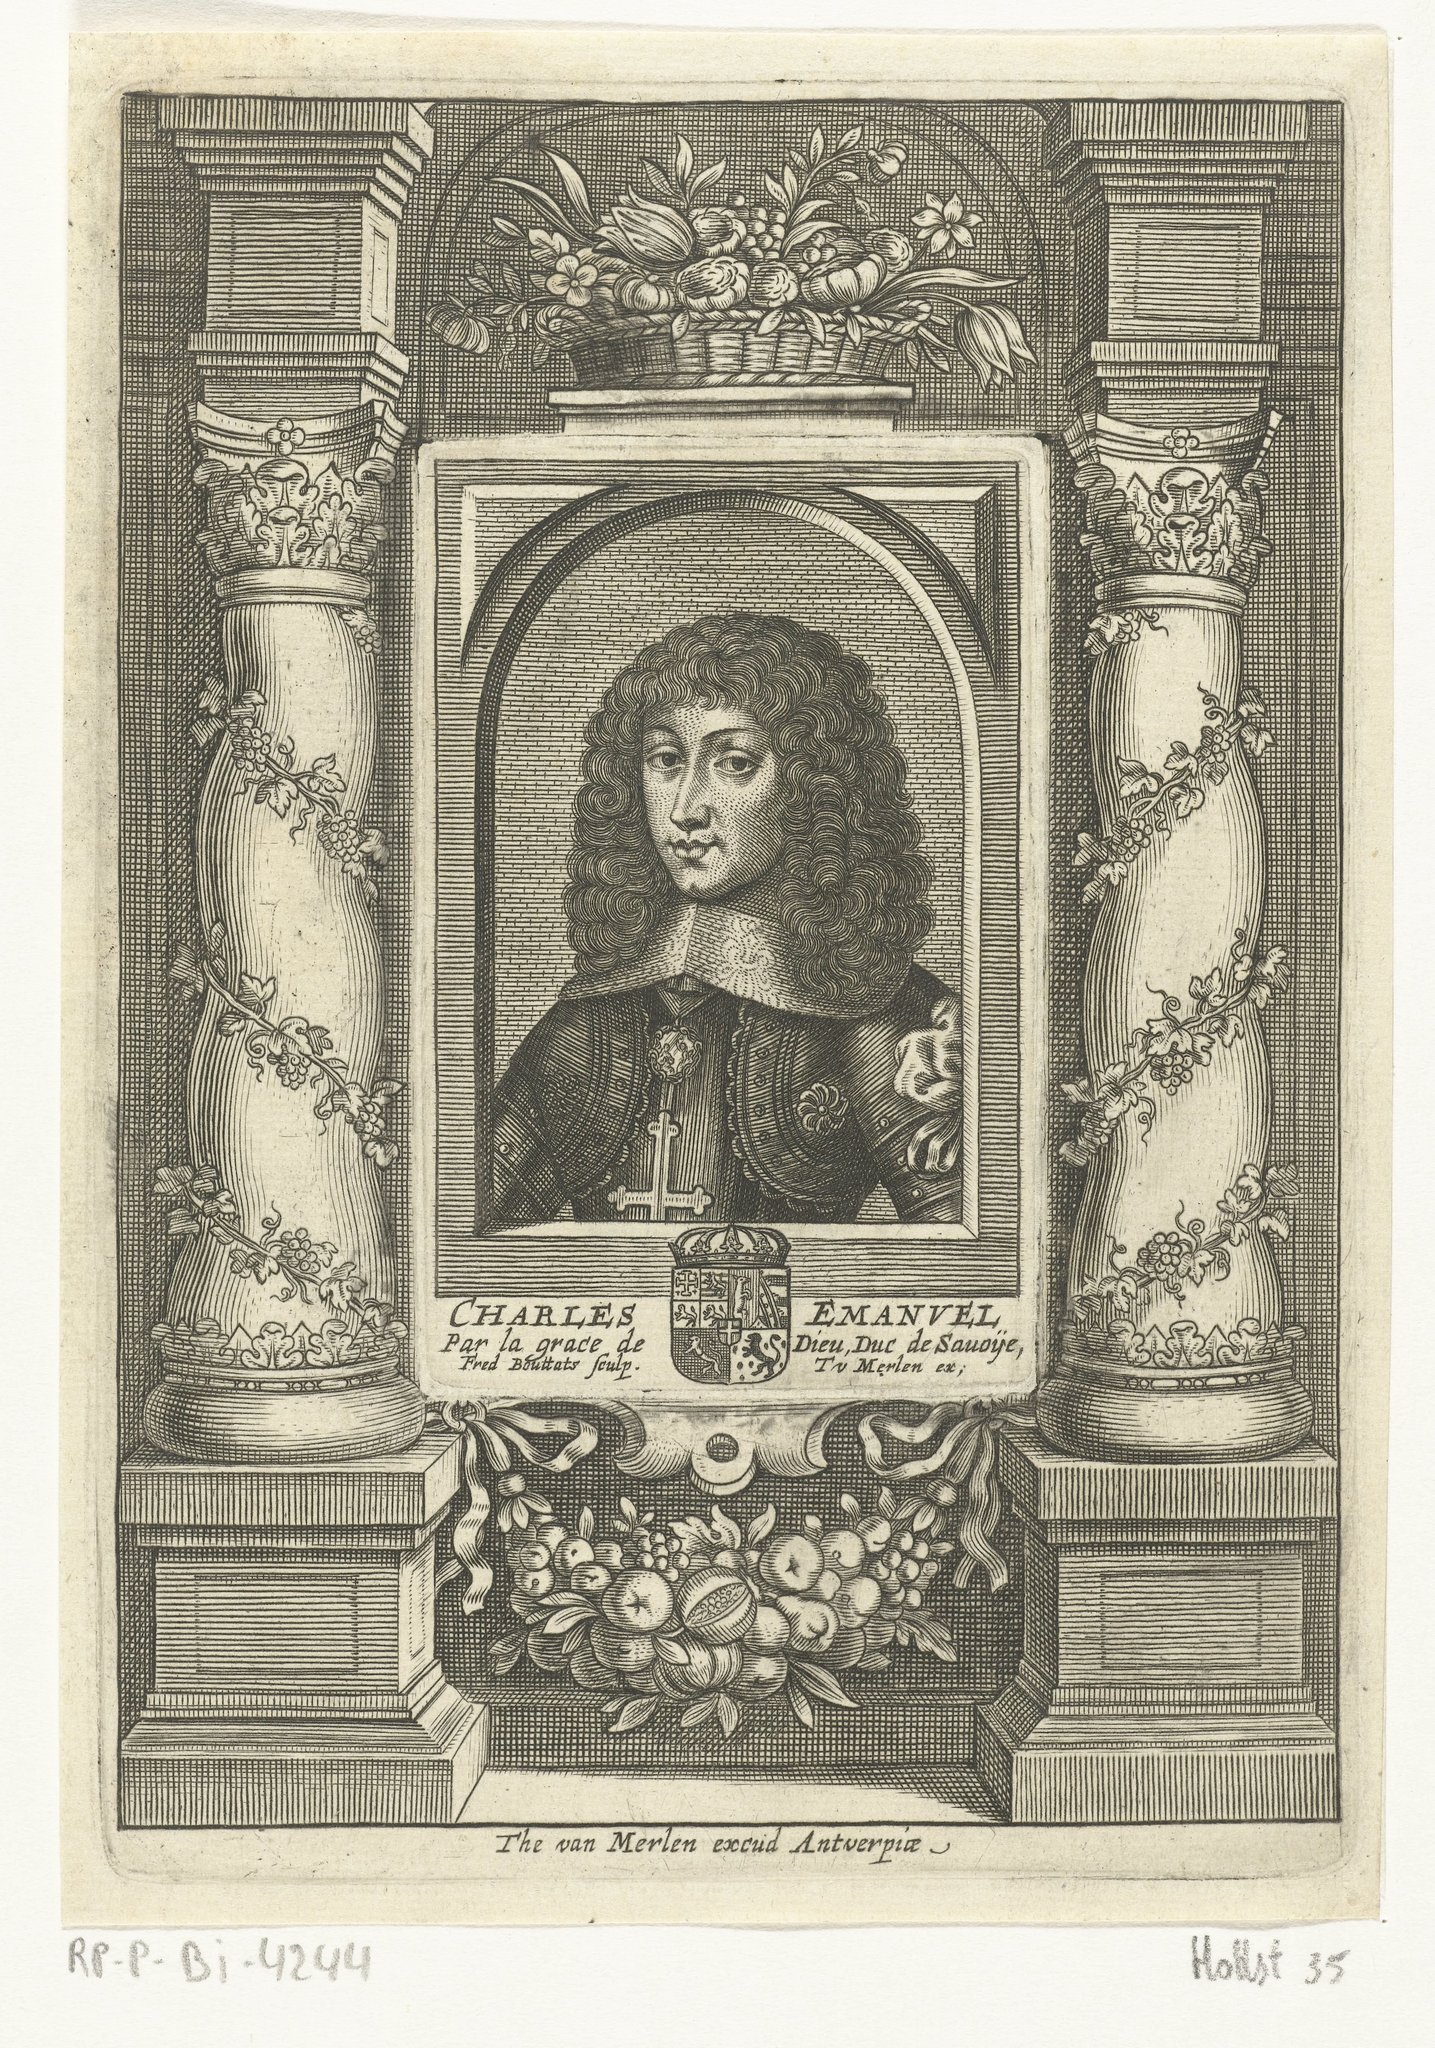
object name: print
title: Portretten van staatslieden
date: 1638-1676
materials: paper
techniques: engraving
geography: antwerp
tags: turijn, karel emanuel ii (hertog van savoye)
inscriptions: collector's mark: Lugt 2228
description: Een rechthoekig portret van Karel-Emanuel II, hertog van Savoye. Buste naar links. Karel-Emanuel draagt een harnas. Het rechthoekig portret staat tussen twee zuilen met wijnranken. De prent heeft een Frans onderschrift met de naam van de geportretteerde.